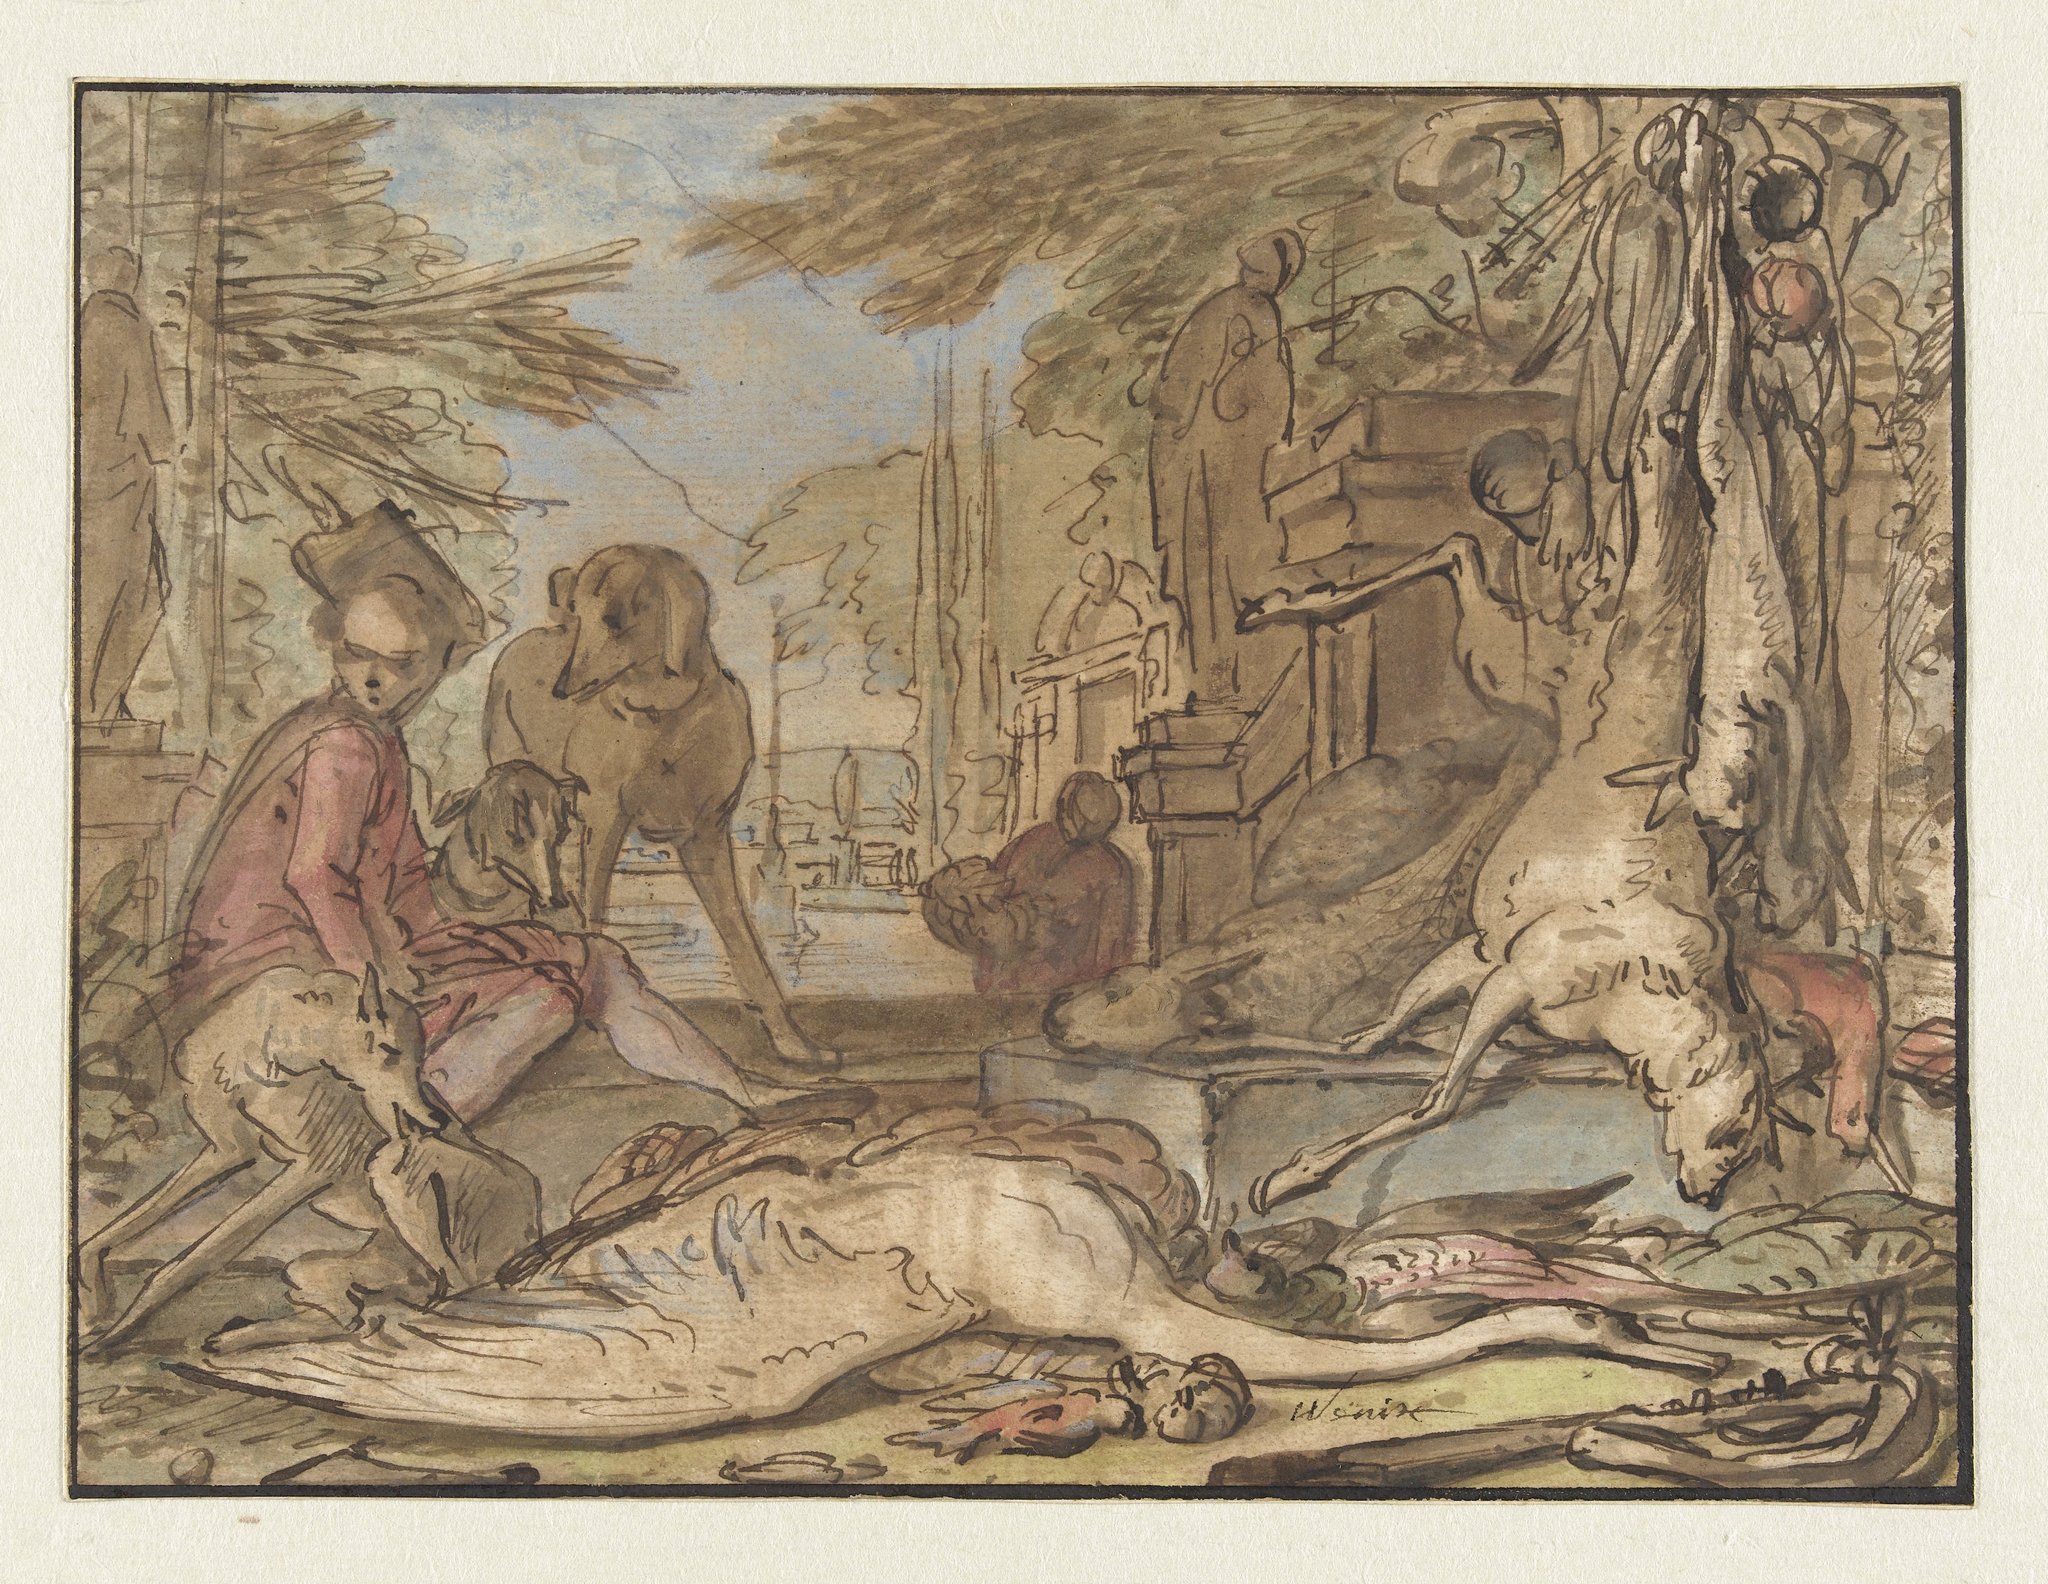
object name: drawing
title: Stilleven van wild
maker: jan weenix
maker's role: draughtsman, painter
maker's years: 1640-1719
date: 1650-1719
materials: ink, paper, watercolor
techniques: brush, pen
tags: spoils of the hunt, game, venison, foodstuffs; still life of foodstuffs